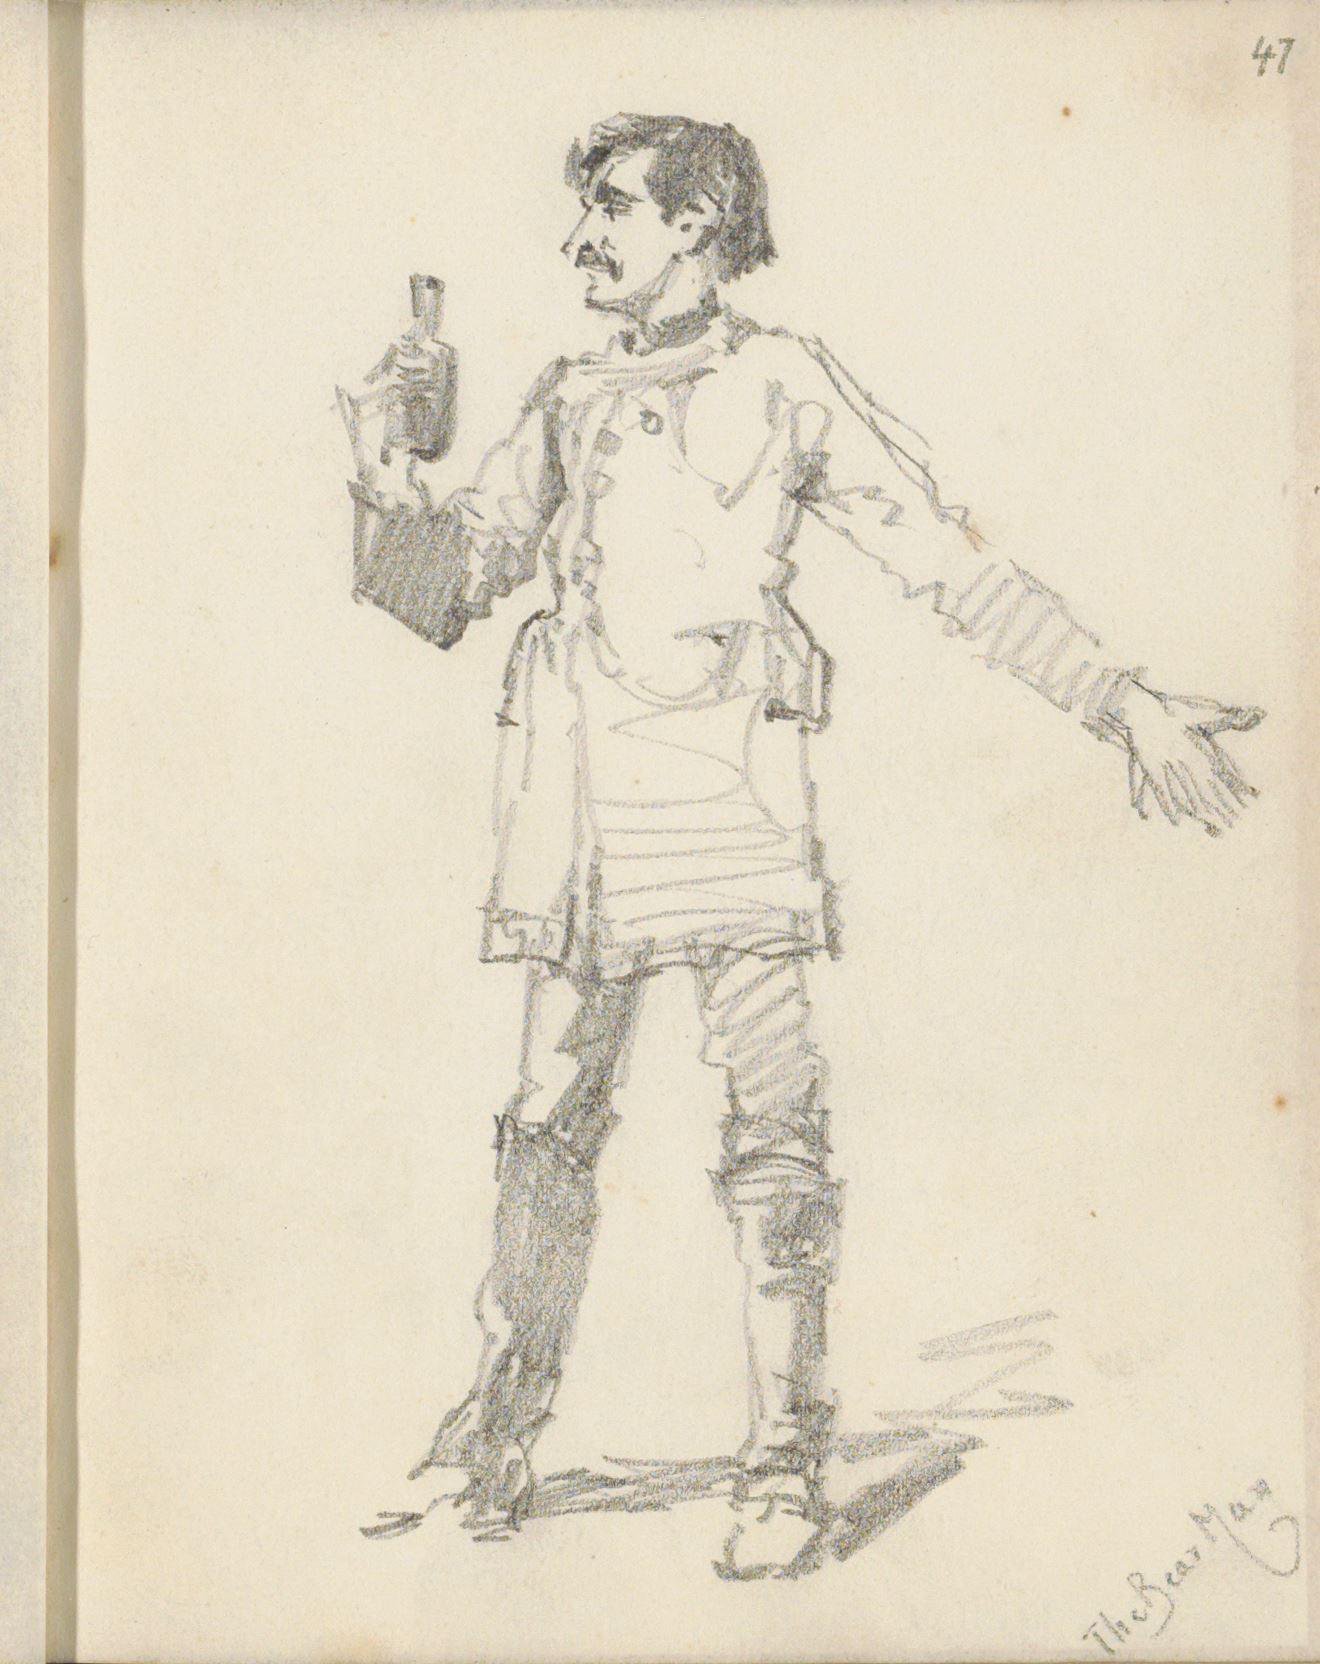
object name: sketchbook leaf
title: Bereneigenaar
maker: alfred william rich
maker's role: draughtsman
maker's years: 1856-1921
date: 1892-1893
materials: paper, pencil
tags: standing figure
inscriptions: annotation: ‘The Bear Man’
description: De man draagt hoge laarzen en een jas. Hij heeft een fles in zijn rechterhand en wijst met zijn uitgestrekte linkerhand richting de grond. Blad 47 recto uit een schetsboek met 86 bladen.